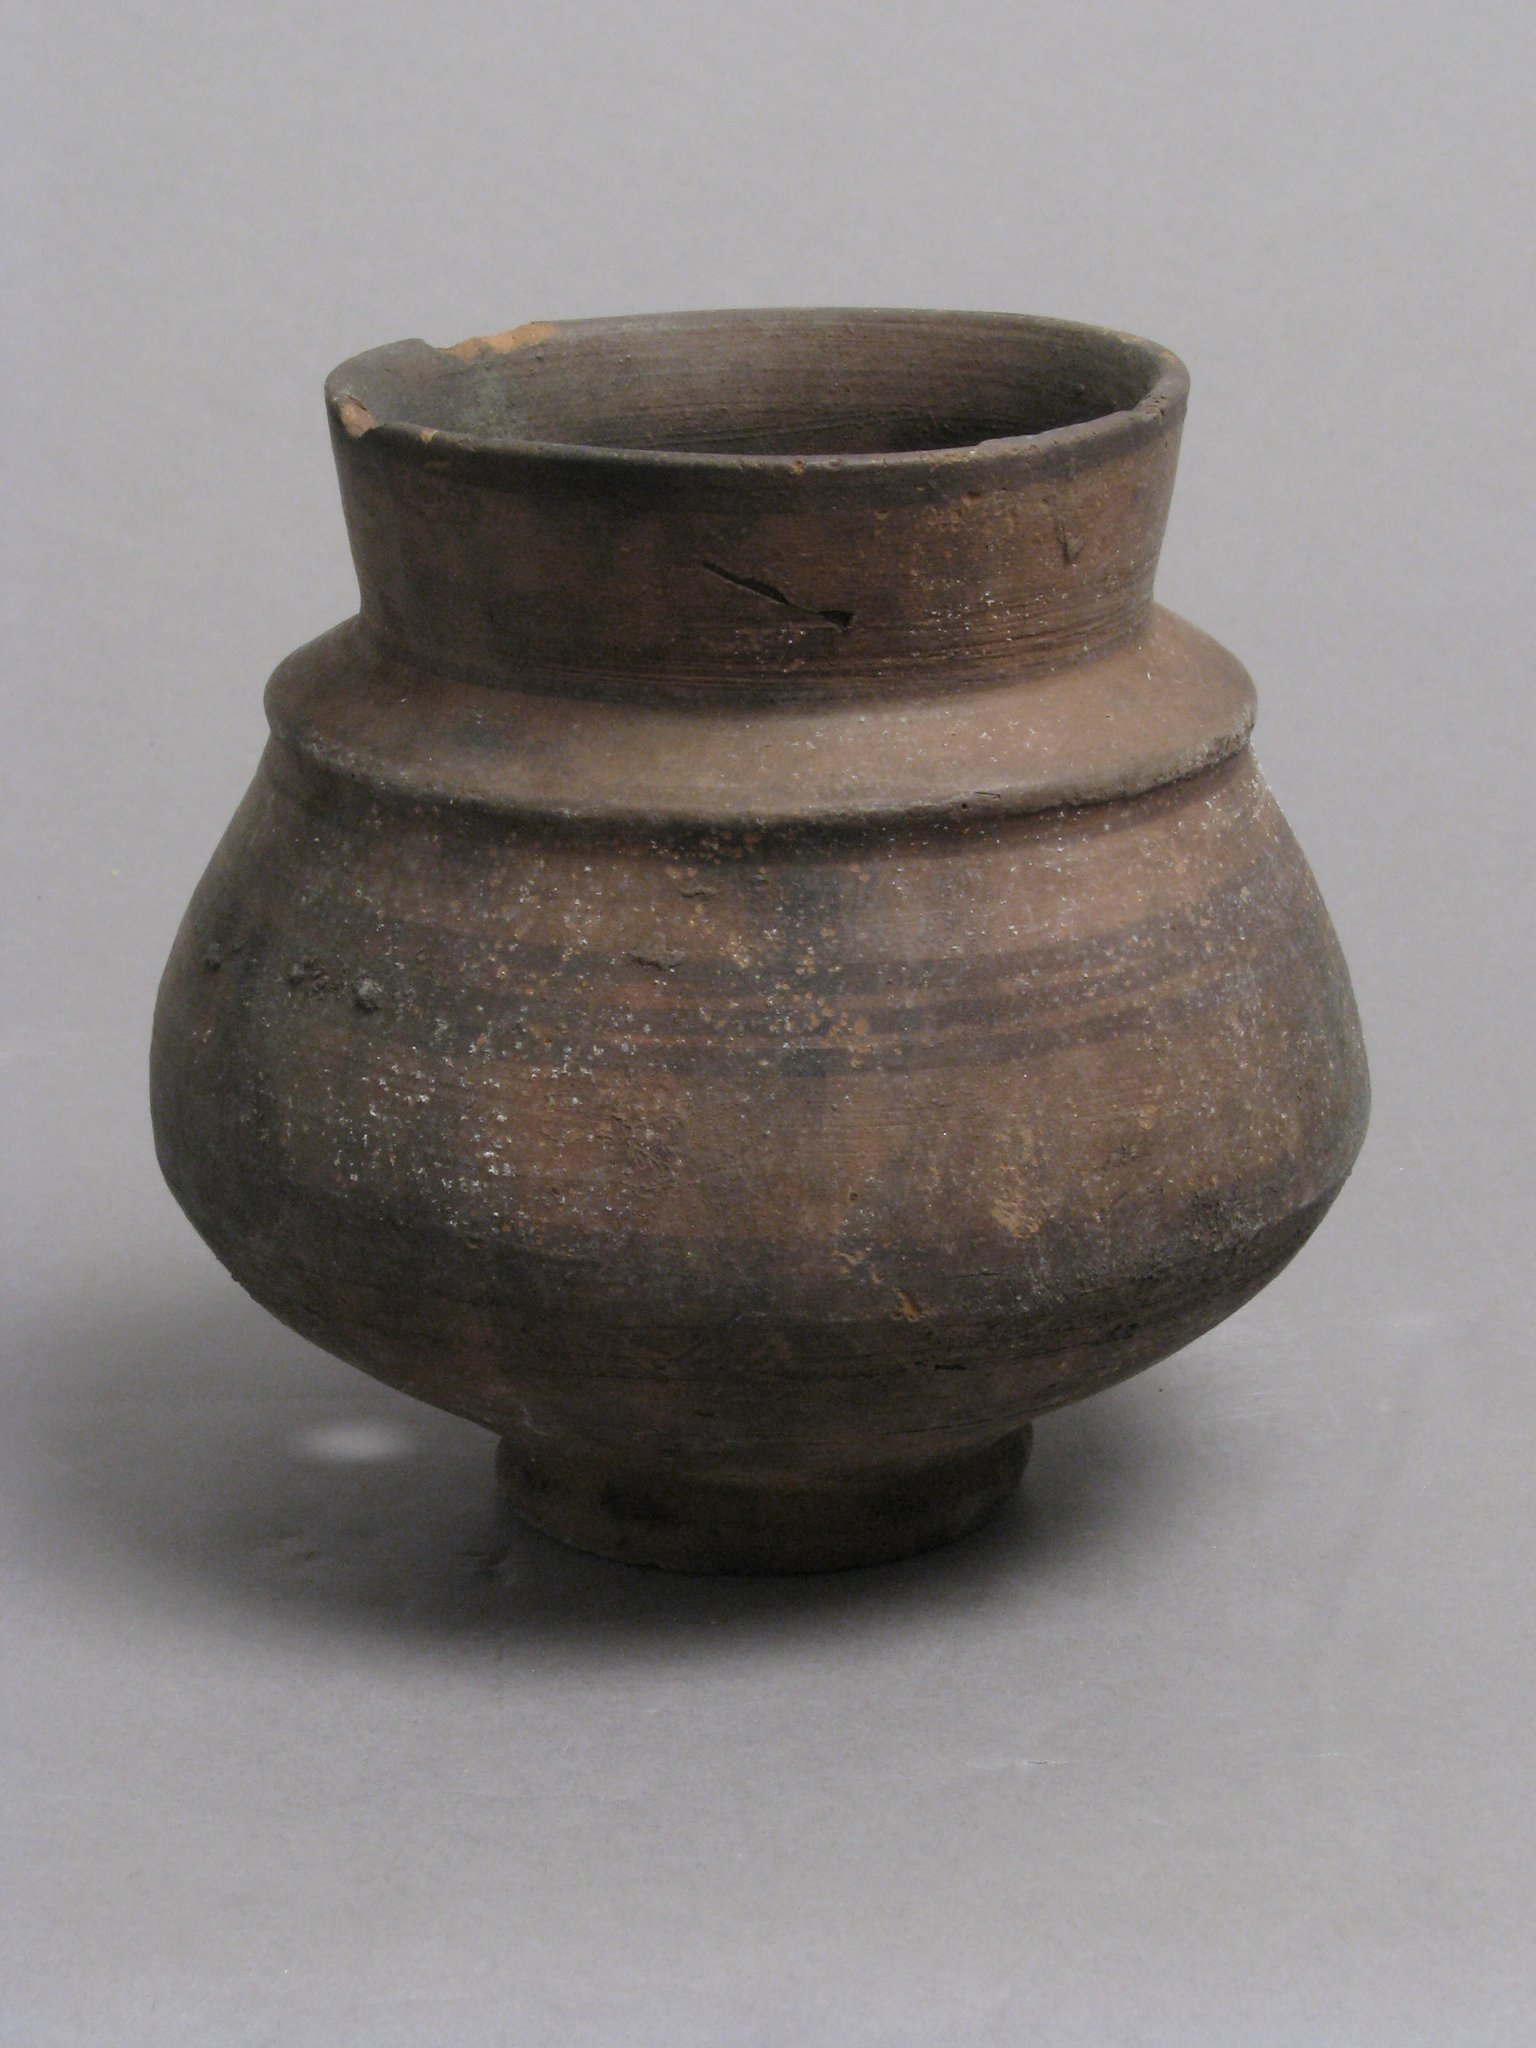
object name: jar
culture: coptic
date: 301-700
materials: earthenware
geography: egypt